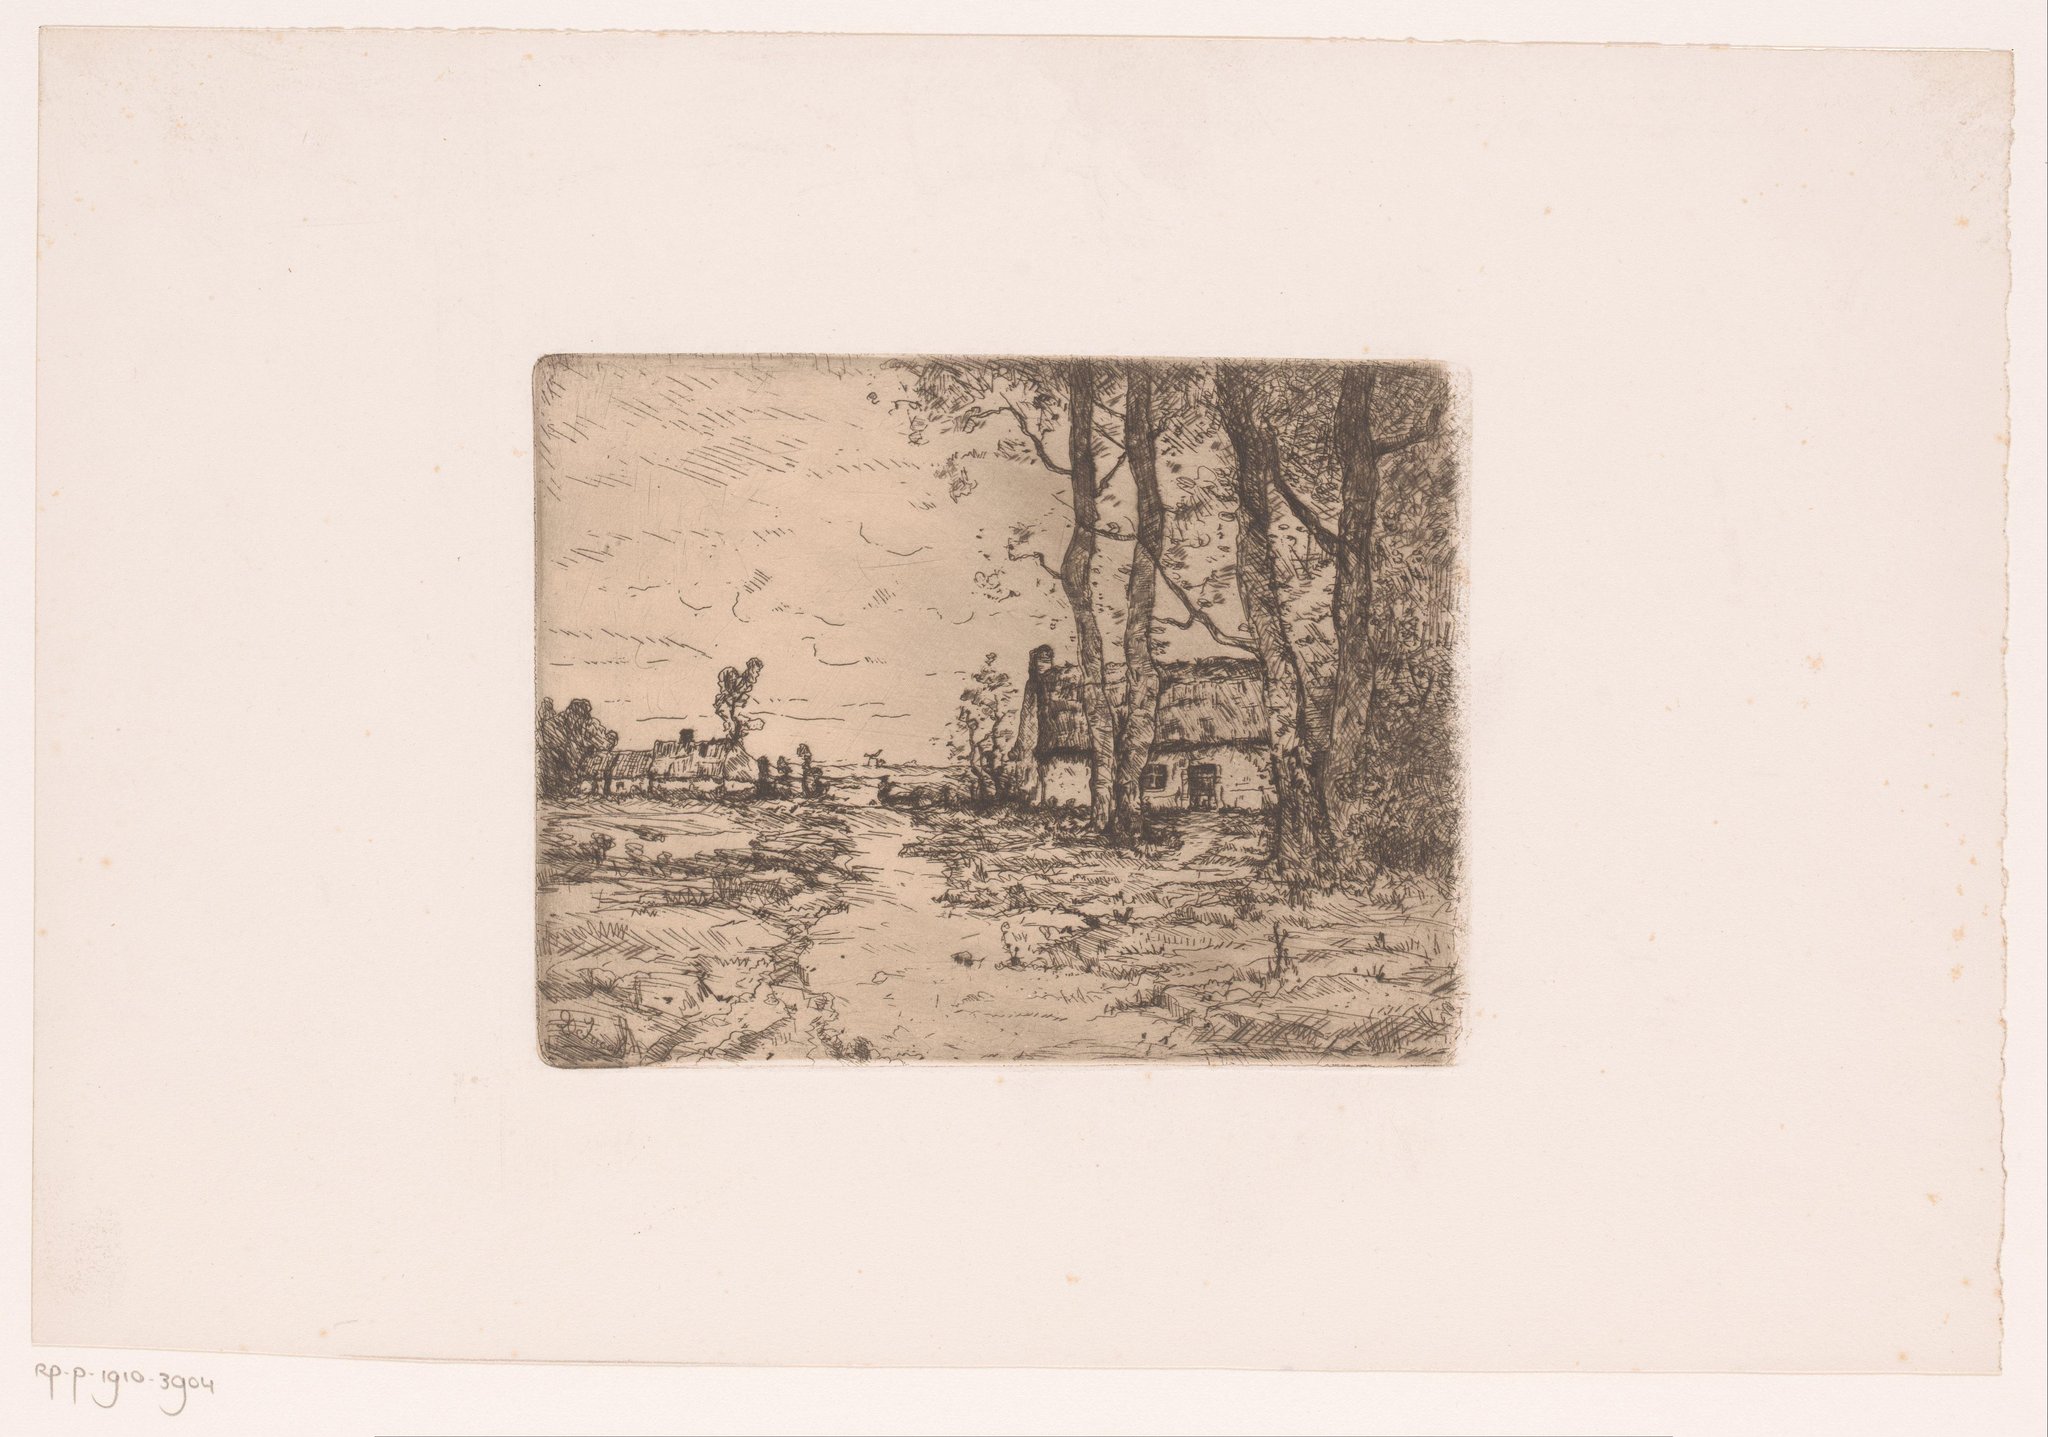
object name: print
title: Landschap met een pad tussen twee boerderijen door, in de achtergrond een molen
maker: louis adolphe jacobs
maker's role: painter, print maker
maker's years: 1855-1929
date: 1865-1910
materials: paper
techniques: etching, intaglio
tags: farm or solitary house in landscape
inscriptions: collector's mark: Lugt 2228